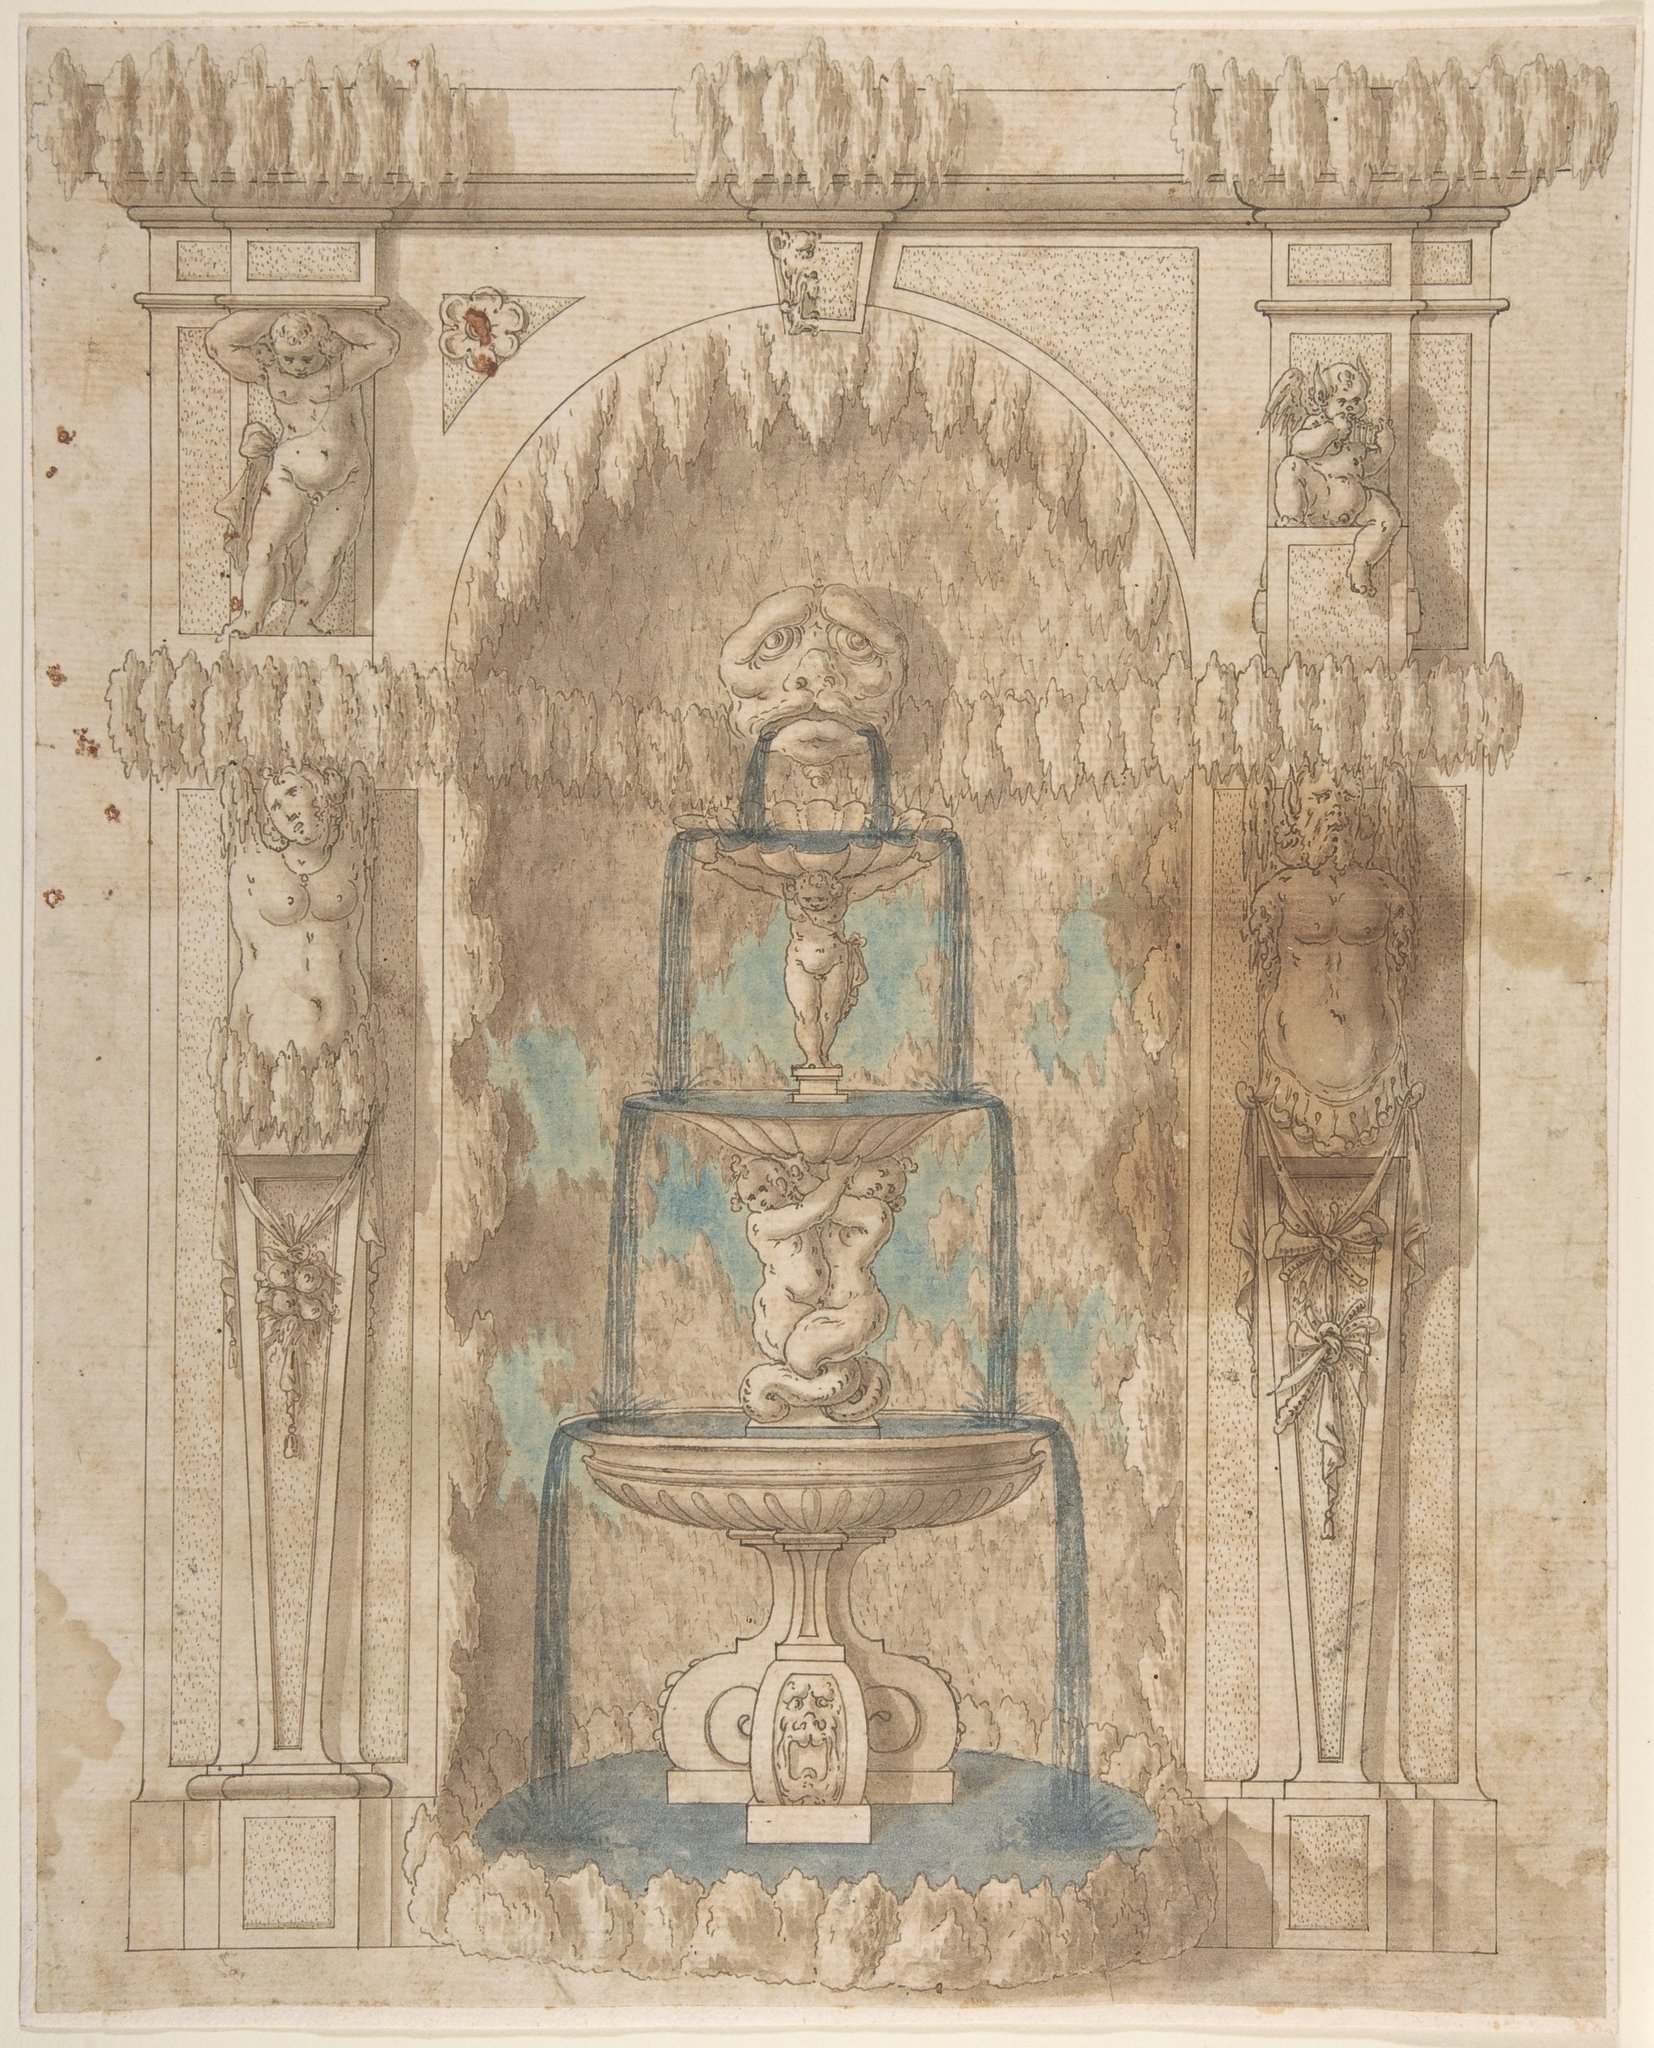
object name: drawing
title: Design for a Grotto with a Fountain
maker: anonymous, italian, 17th century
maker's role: artist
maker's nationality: italian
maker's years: 1600-1700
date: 1601-1700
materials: ink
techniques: brush, pen, wash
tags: fountains